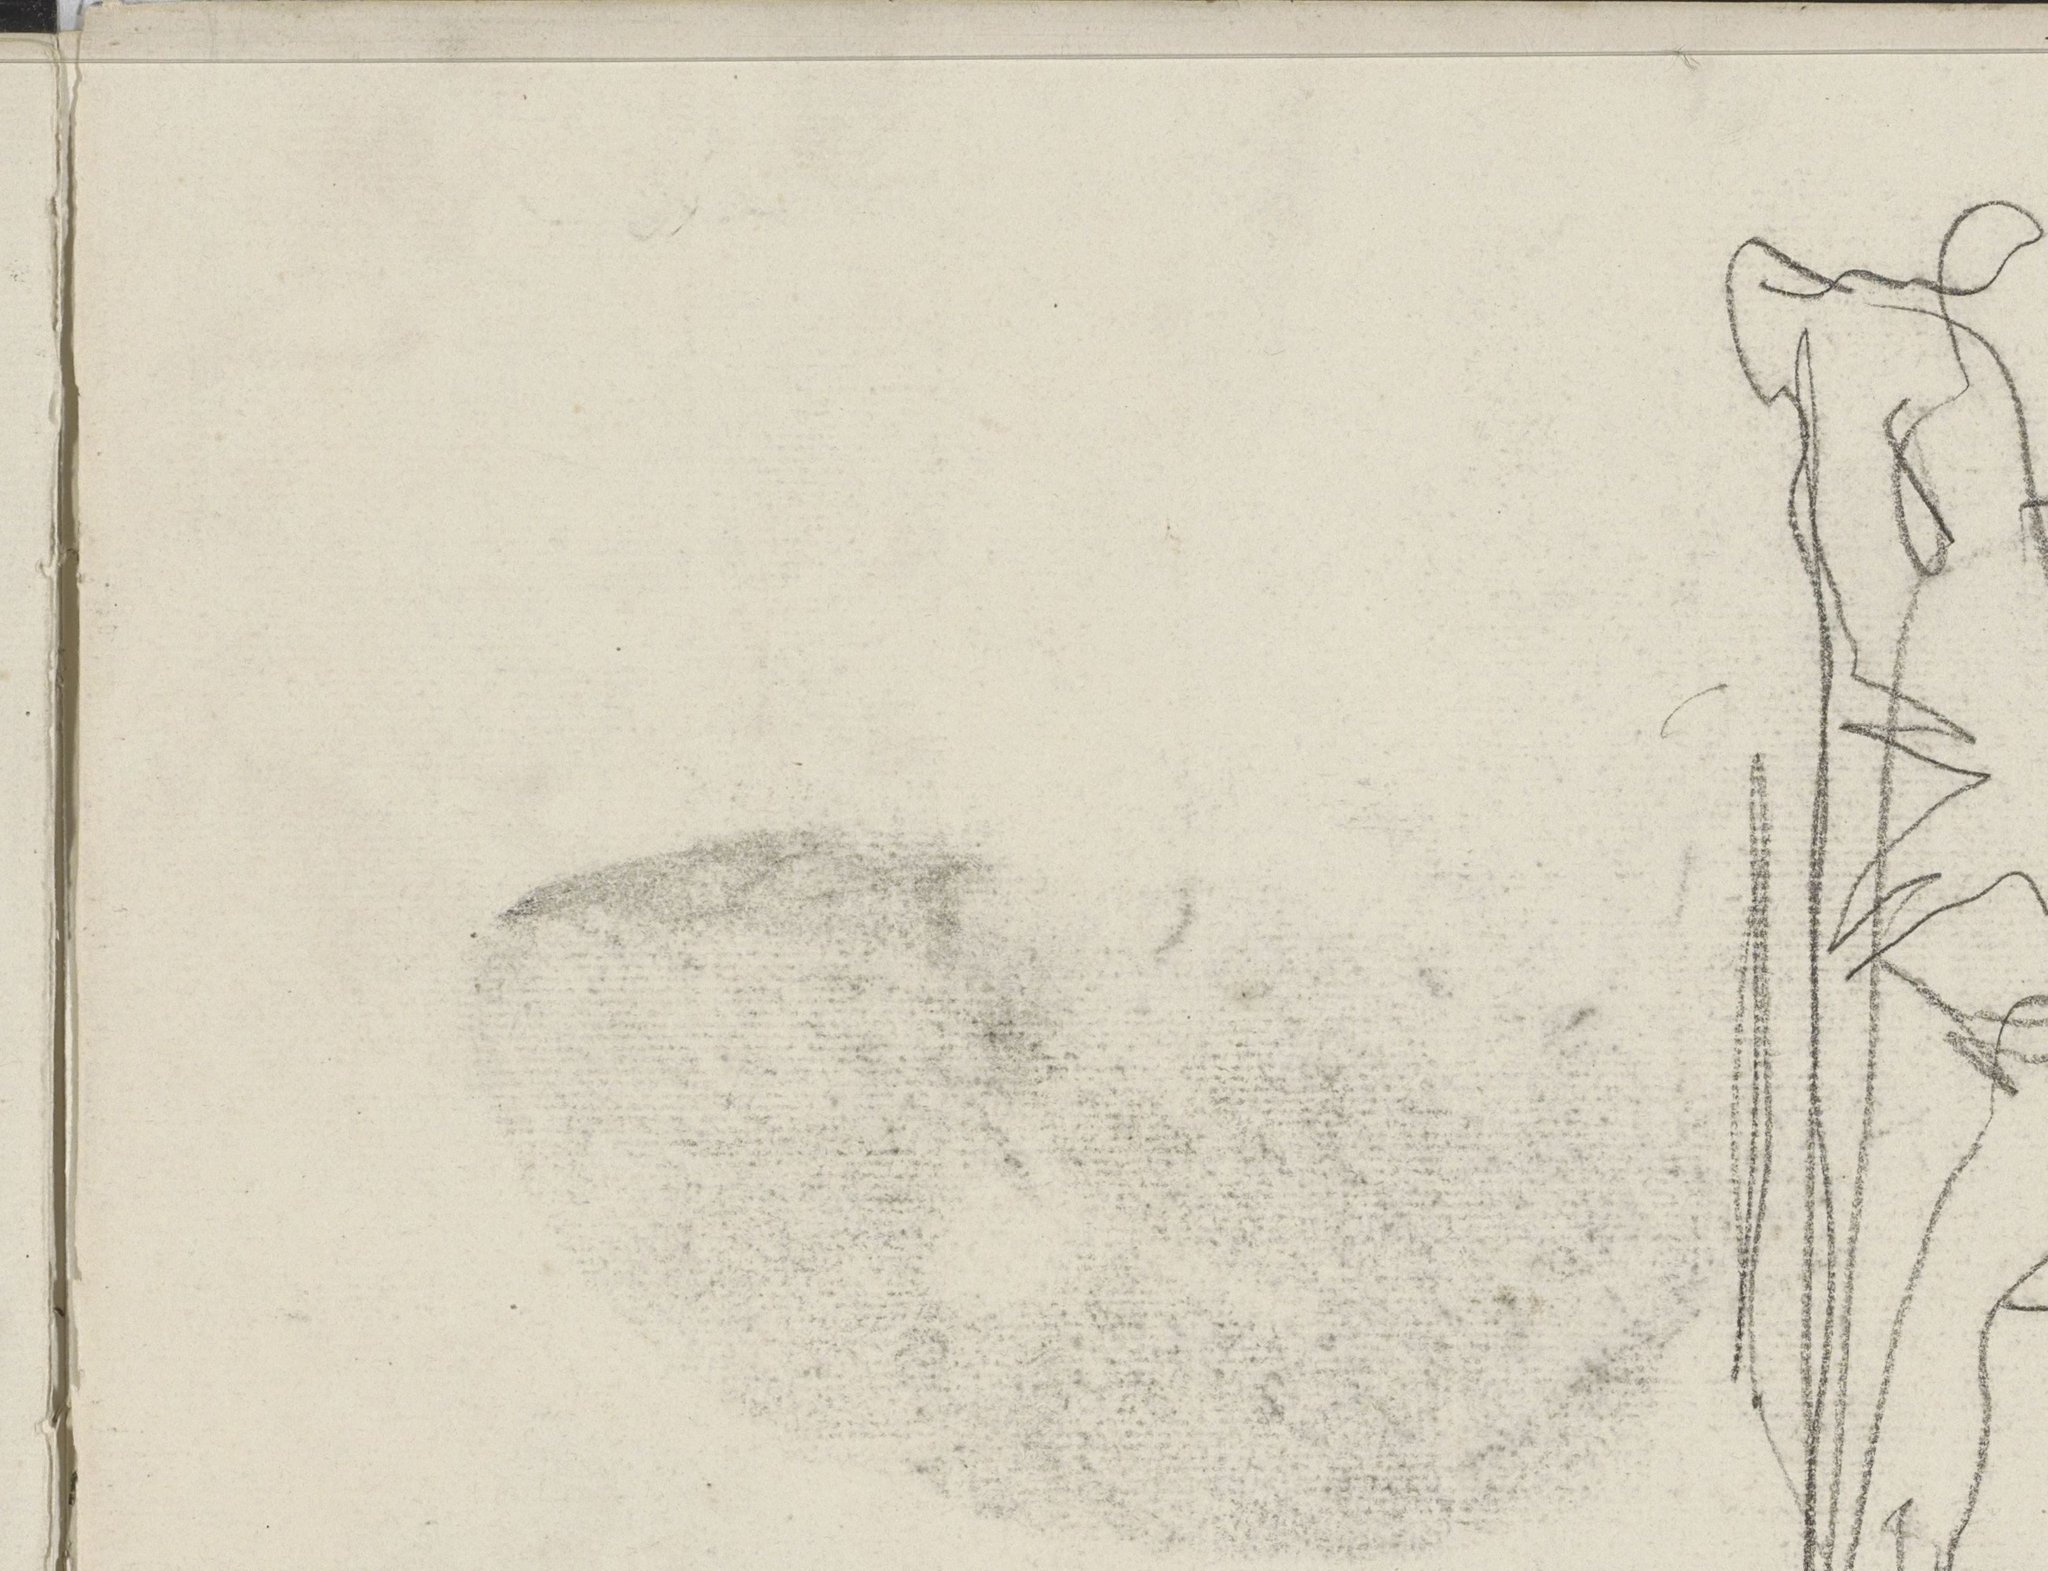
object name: sketchbook leaf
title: Studie, mogelijk een ornament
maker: carel adolph lion cachet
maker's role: draughtsman, print maker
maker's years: 1864-1945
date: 1896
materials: chalk, paper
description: Blad 17 recto uit een schetsboek met 44 bladen.